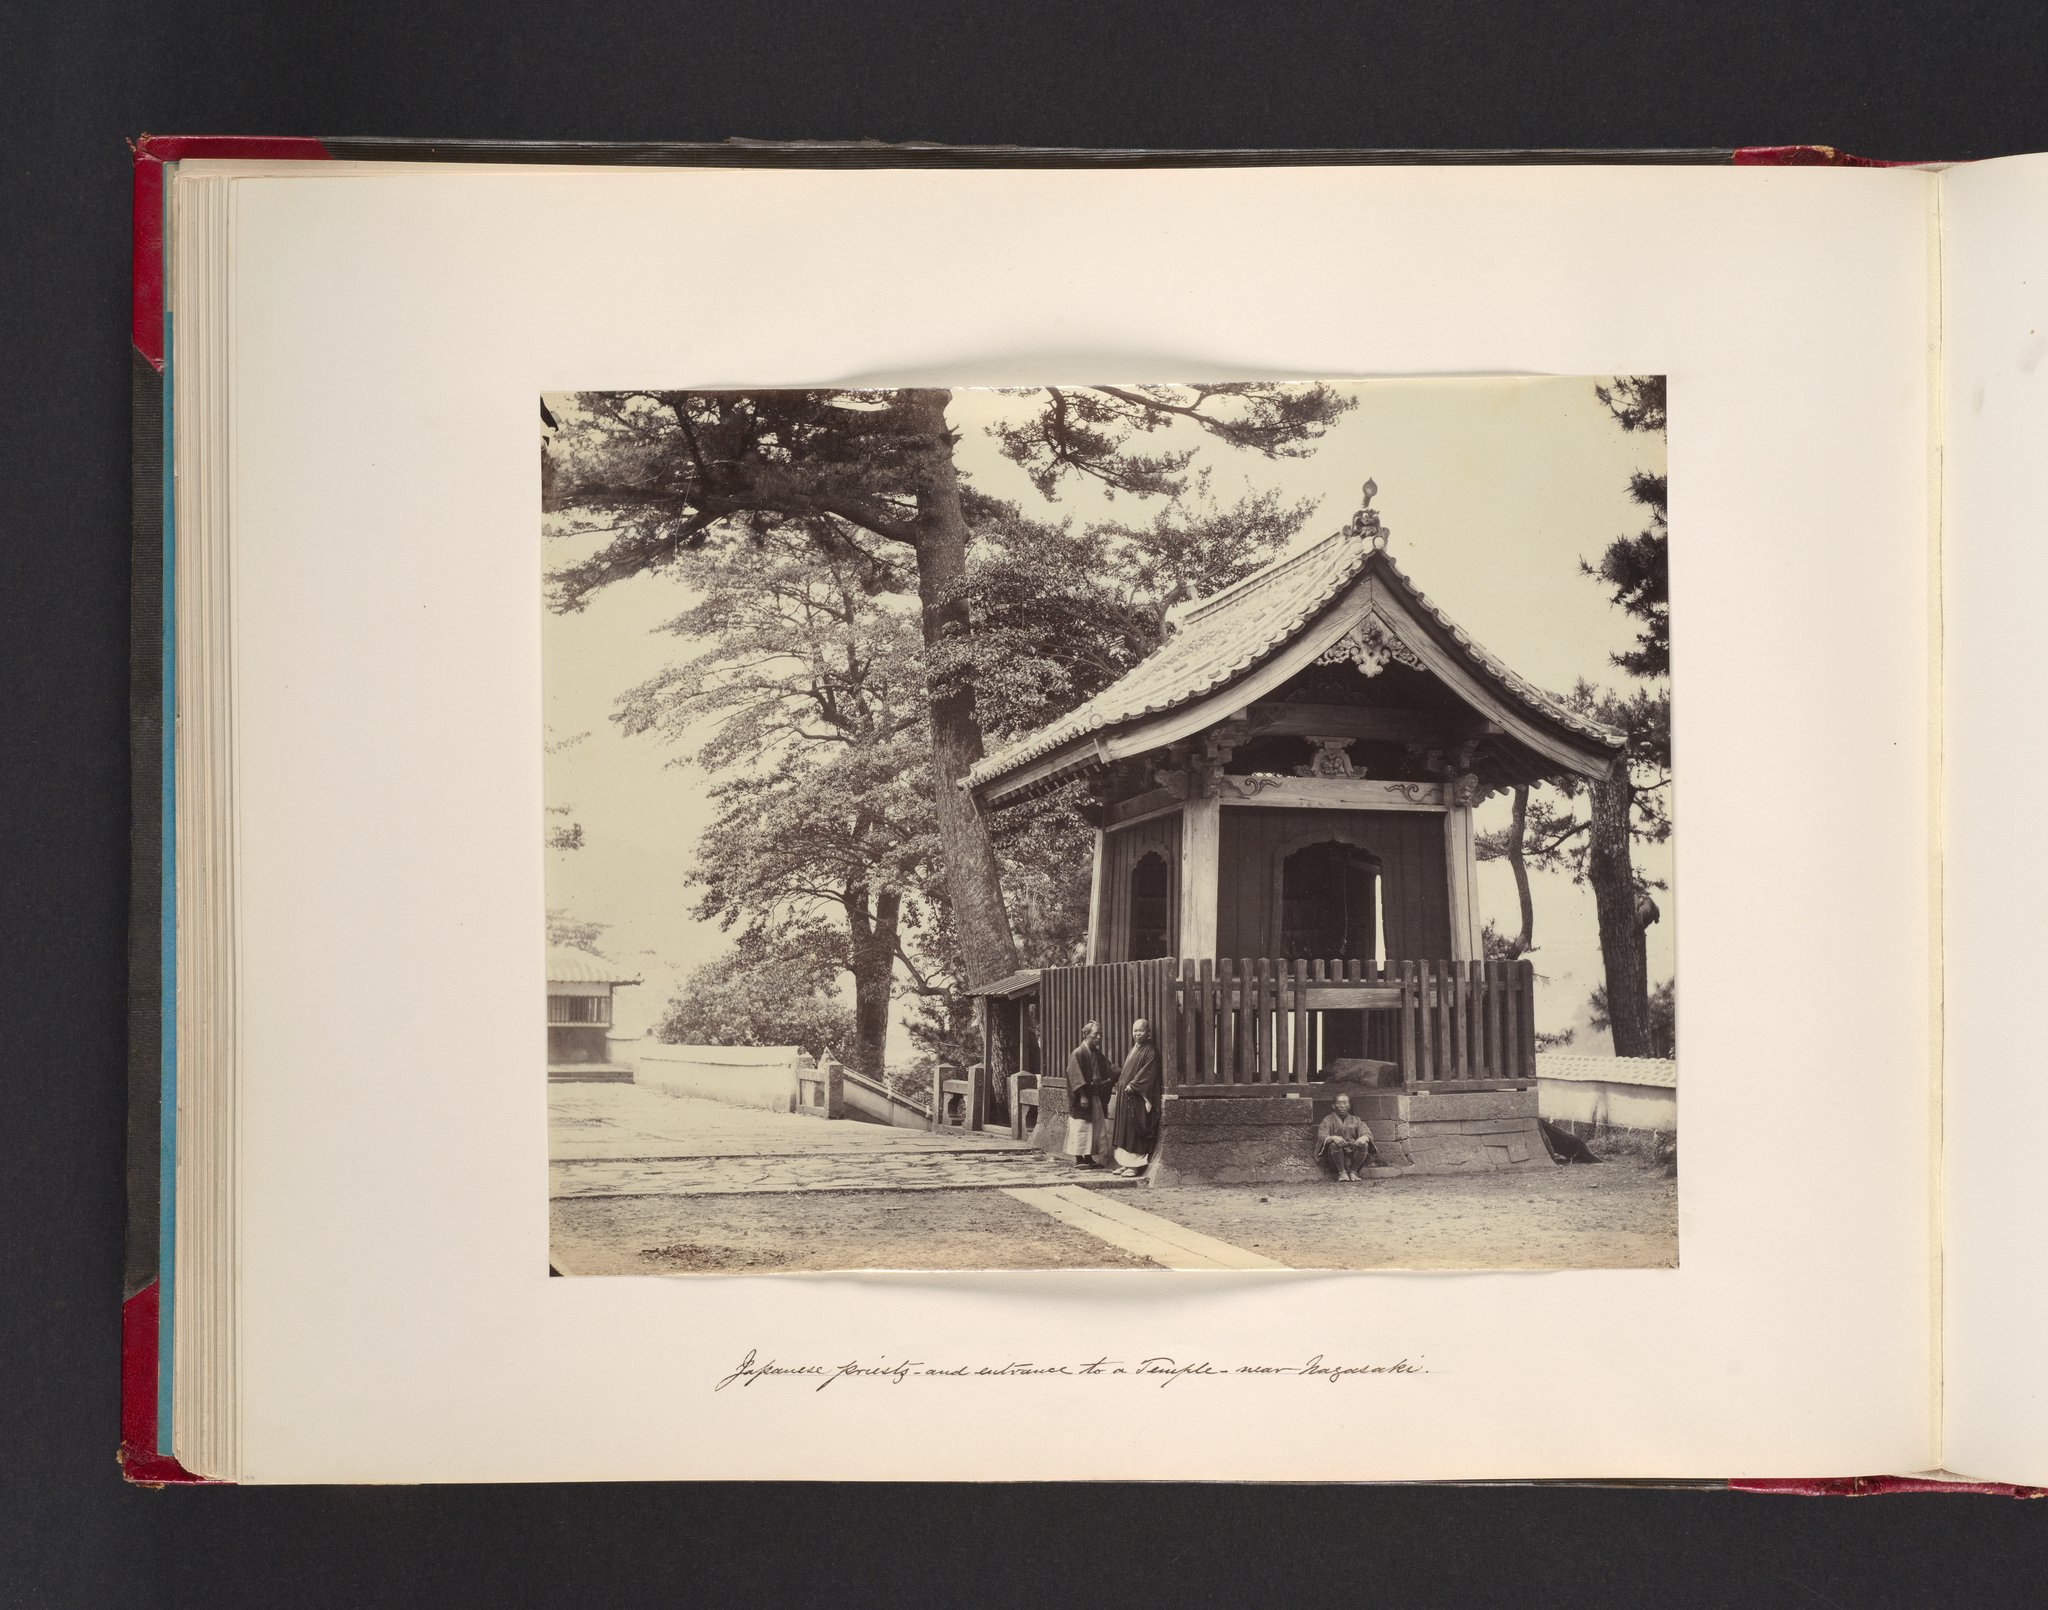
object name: photograph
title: Japanese Priests and Entrance to a Temple, Near Nagasaki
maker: john thomson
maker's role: artist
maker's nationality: british, scottish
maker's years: 1837-1921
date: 1865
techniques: albumen silver print, glass negative